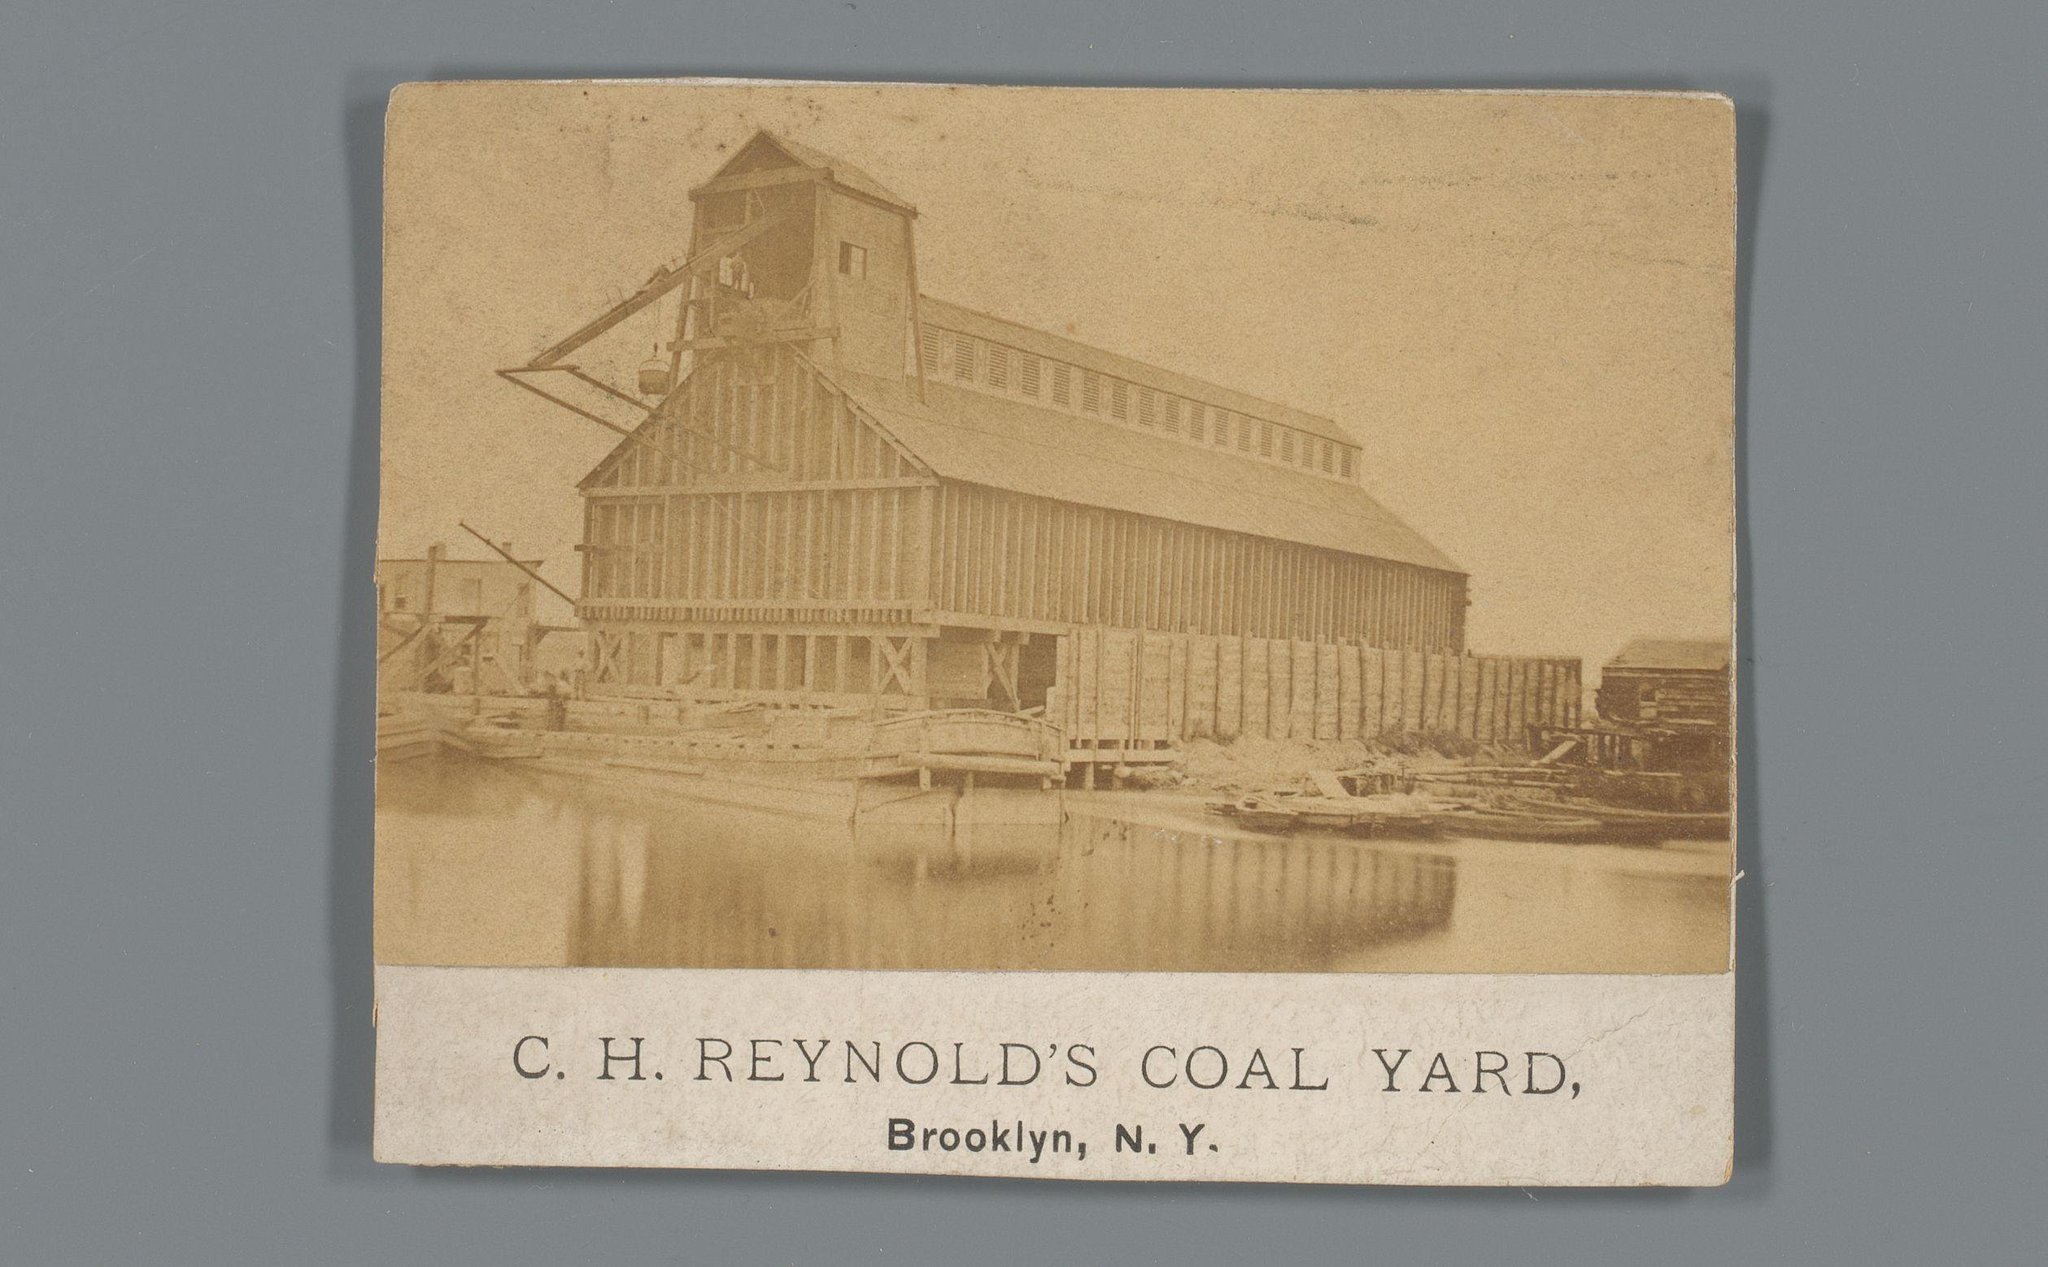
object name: carte de visite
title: Gezicht op een kolenwerf van C.H. Reynold's in Brooklyn, New York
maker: Anonymous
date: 1850-1915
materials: cardboard, photographic support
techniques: albumen print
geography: brooklyn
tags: factory-building, advertising